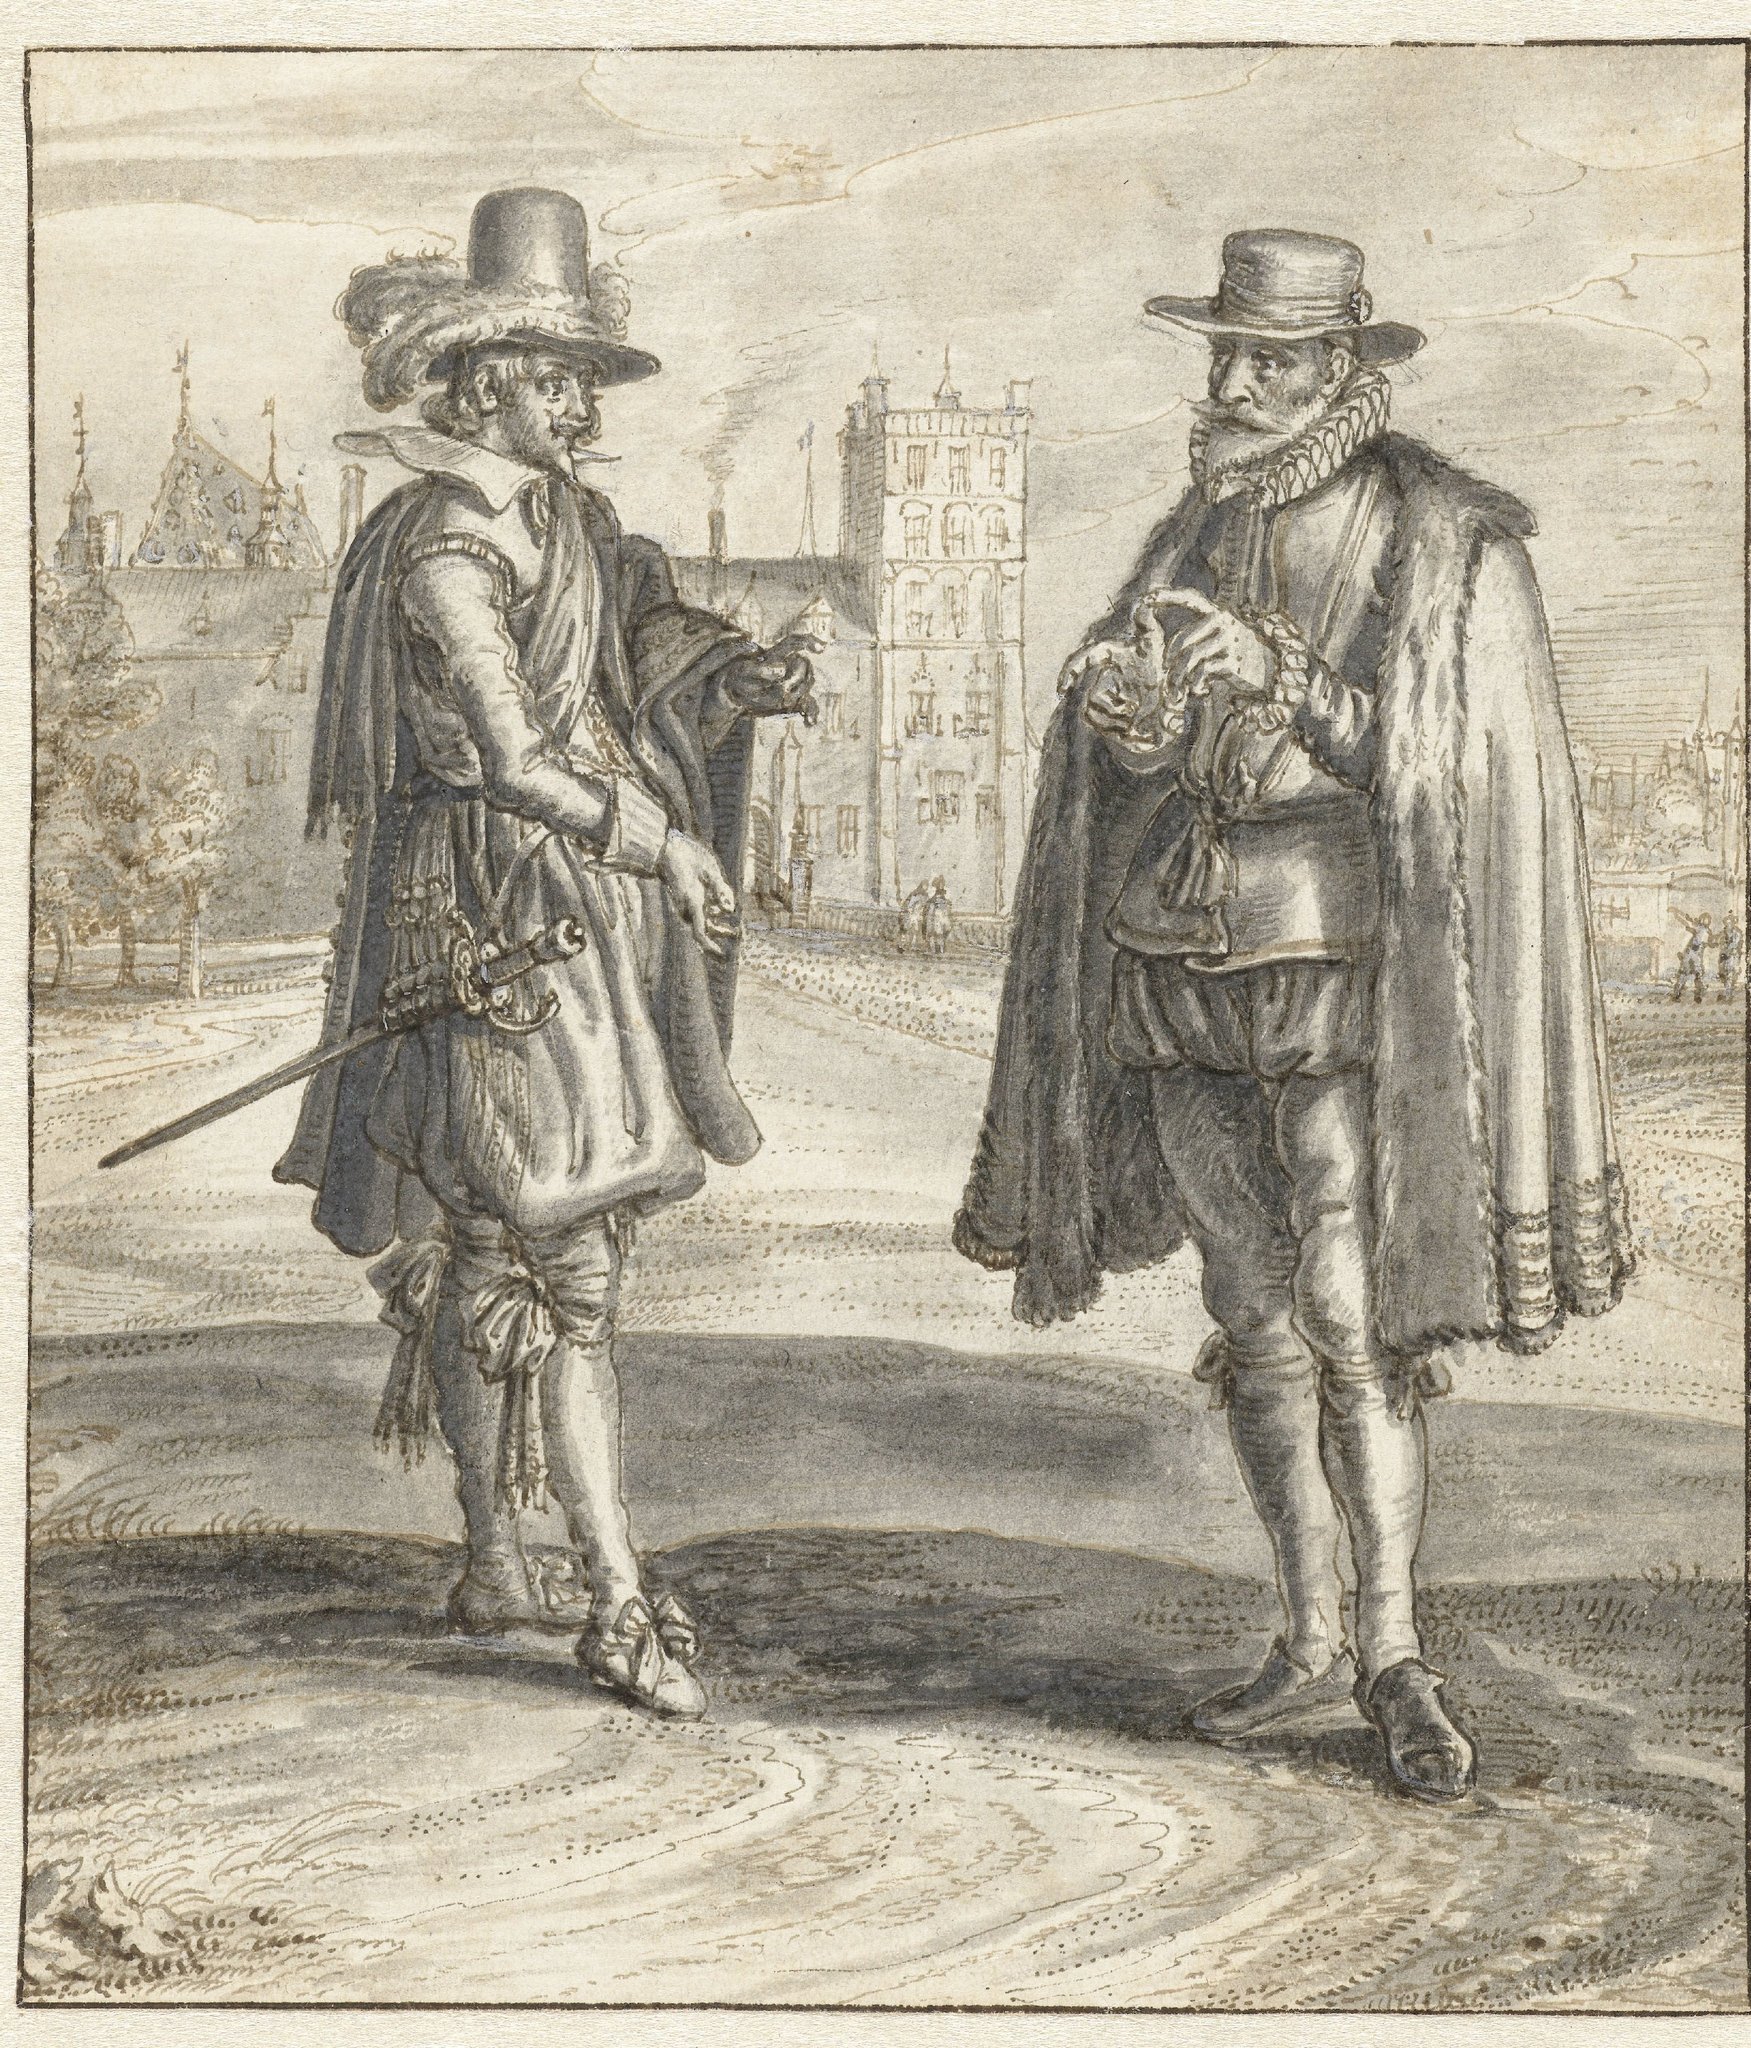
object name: design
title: Two Men Conversing on the Buitenhof, with the Stadholder’s Quarters and the Ridderzaal in the Background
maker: adriaen pietersz van de venne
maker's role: draughtsman, painter, print maker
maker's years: 1589-1662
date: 1600-1662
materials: chalk, paint, ink, paper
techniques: brush, pen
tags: standing figure, neck-gear ~ clothing (with name) (+ men's clothes), cape (+ men's clothes), coat (+ men's clothes), head-gear: hat (+ men's clothes), hacking and thrusting weapons: sword, shoes, sandals (+ men's clothes), neck-gear: collar (+ men's clothes), trousers, breeches, etc. (breeches) (+ men's clothes), clothing for the upper part of the body (doublet) (+ men's clothes), sleeves (+ men's clothes), head-gear: hat (+ feathers used for clothes), the hague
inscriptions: annotation: ‘ick mocht dat verschiet wat goet snijden’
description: Twee heren in gesprek op het Buitenhof; op de achtergrond het Stadhouderlijk Kwartier en de Ridderzaal. De heren zijn gekleed volgens de mode van de bovenklasse ca. 1615-1625. Ontwerp voor een prent.